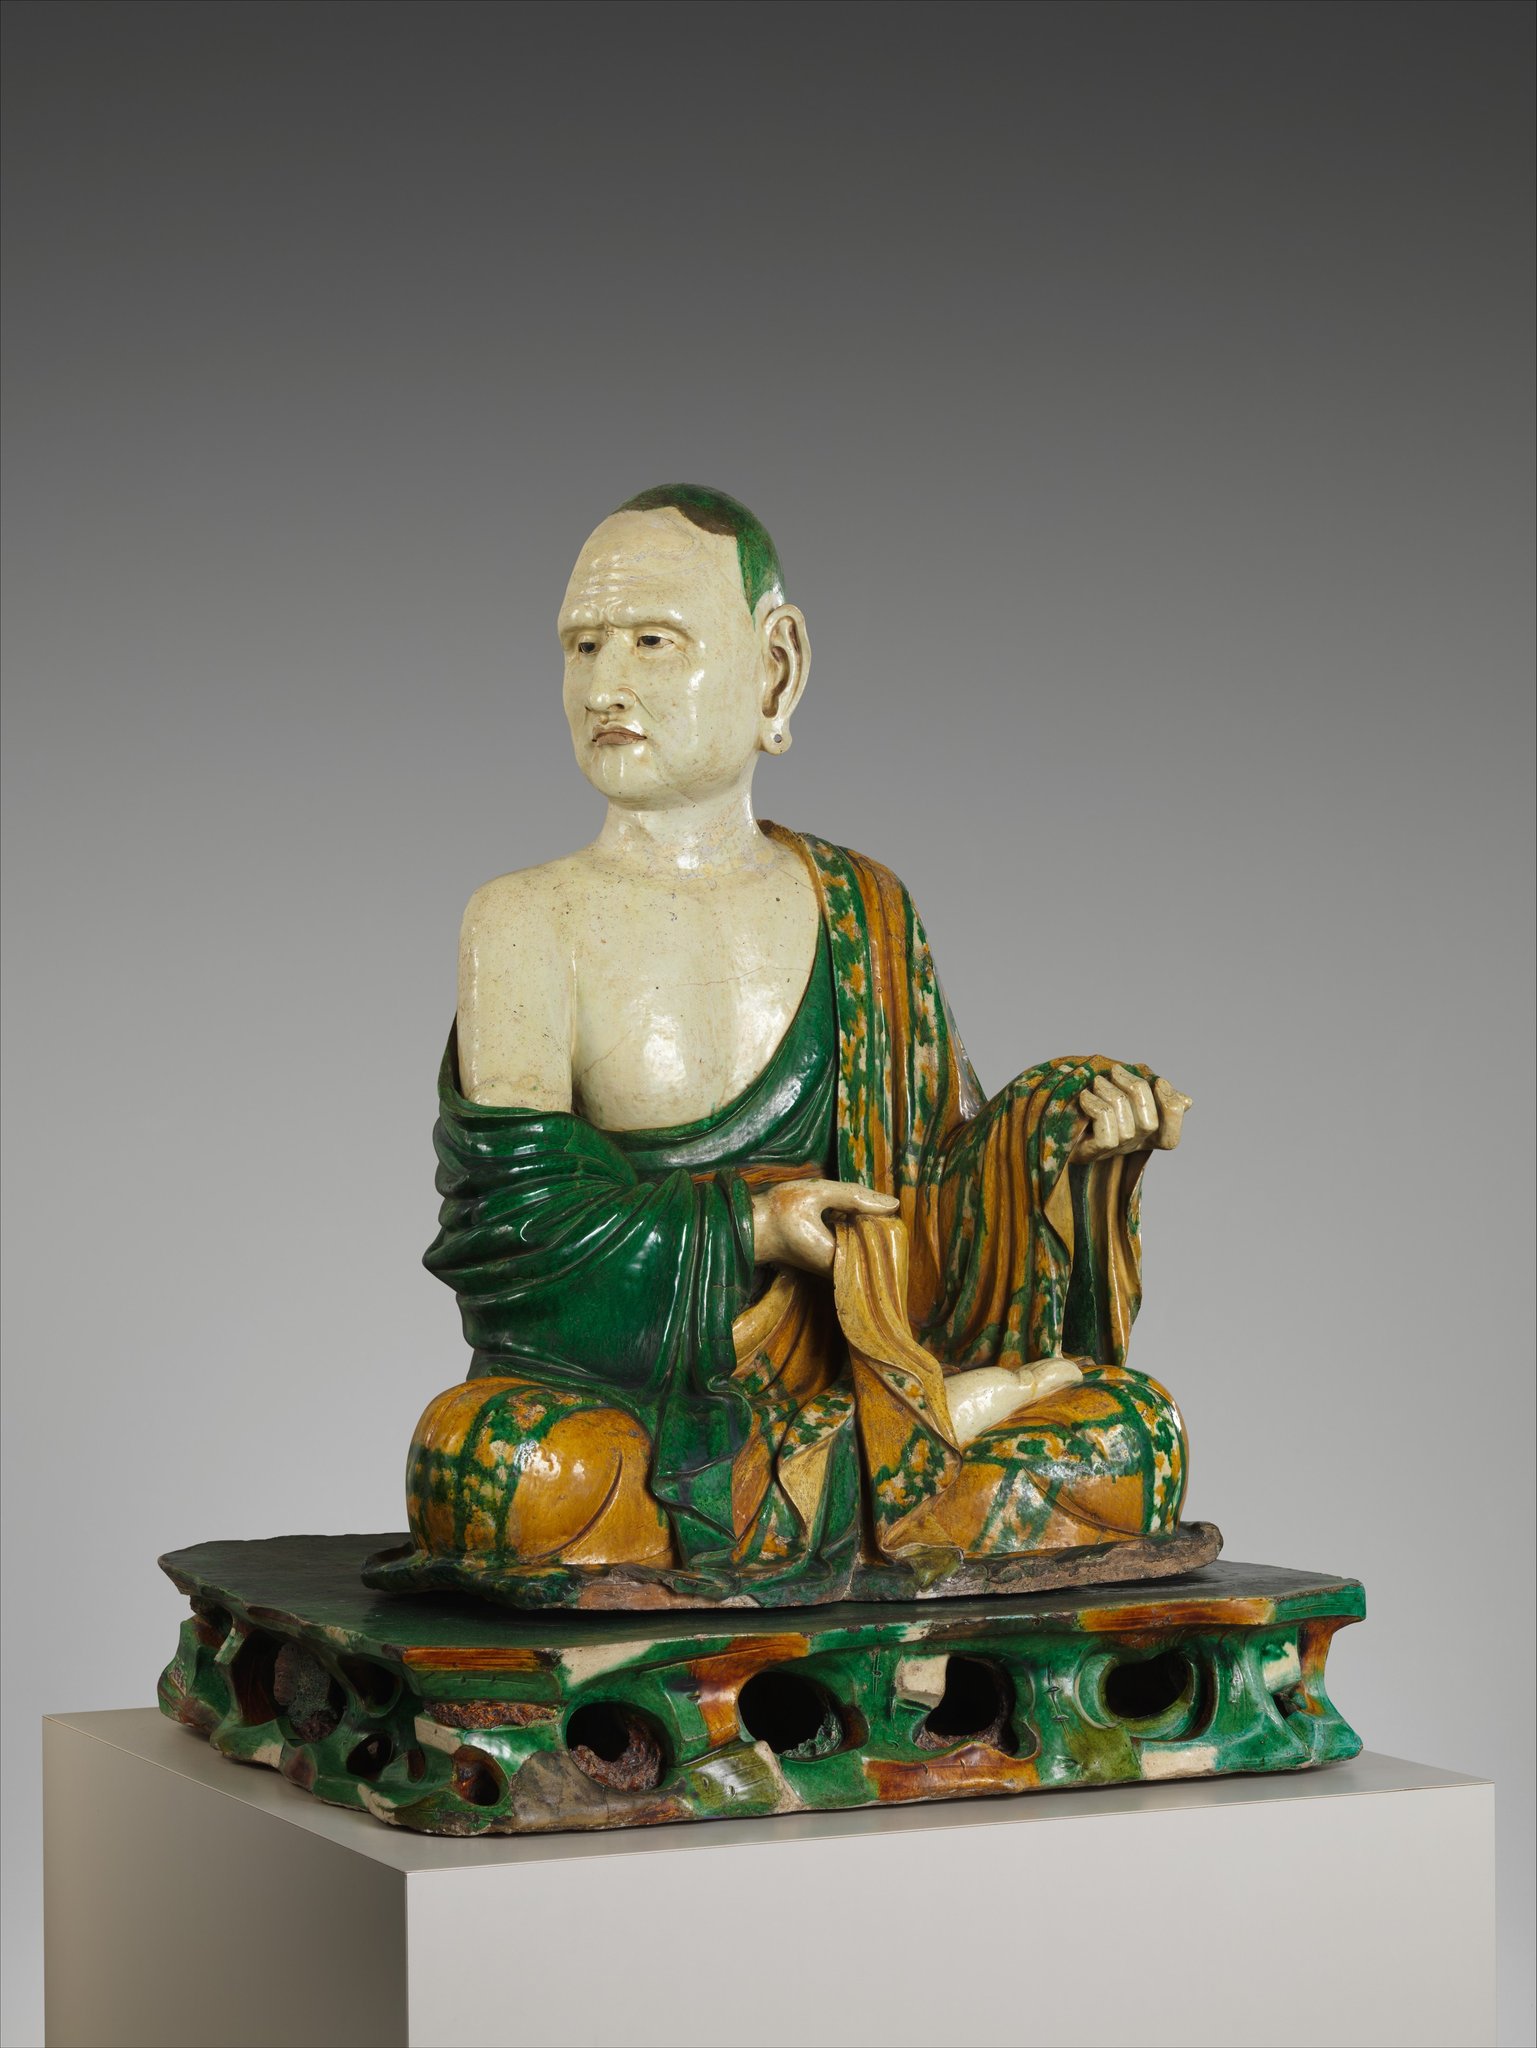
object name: figure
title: Arhat (Luohan)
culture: chinese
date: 1000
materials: glaze, stoneware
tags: men,buddhism